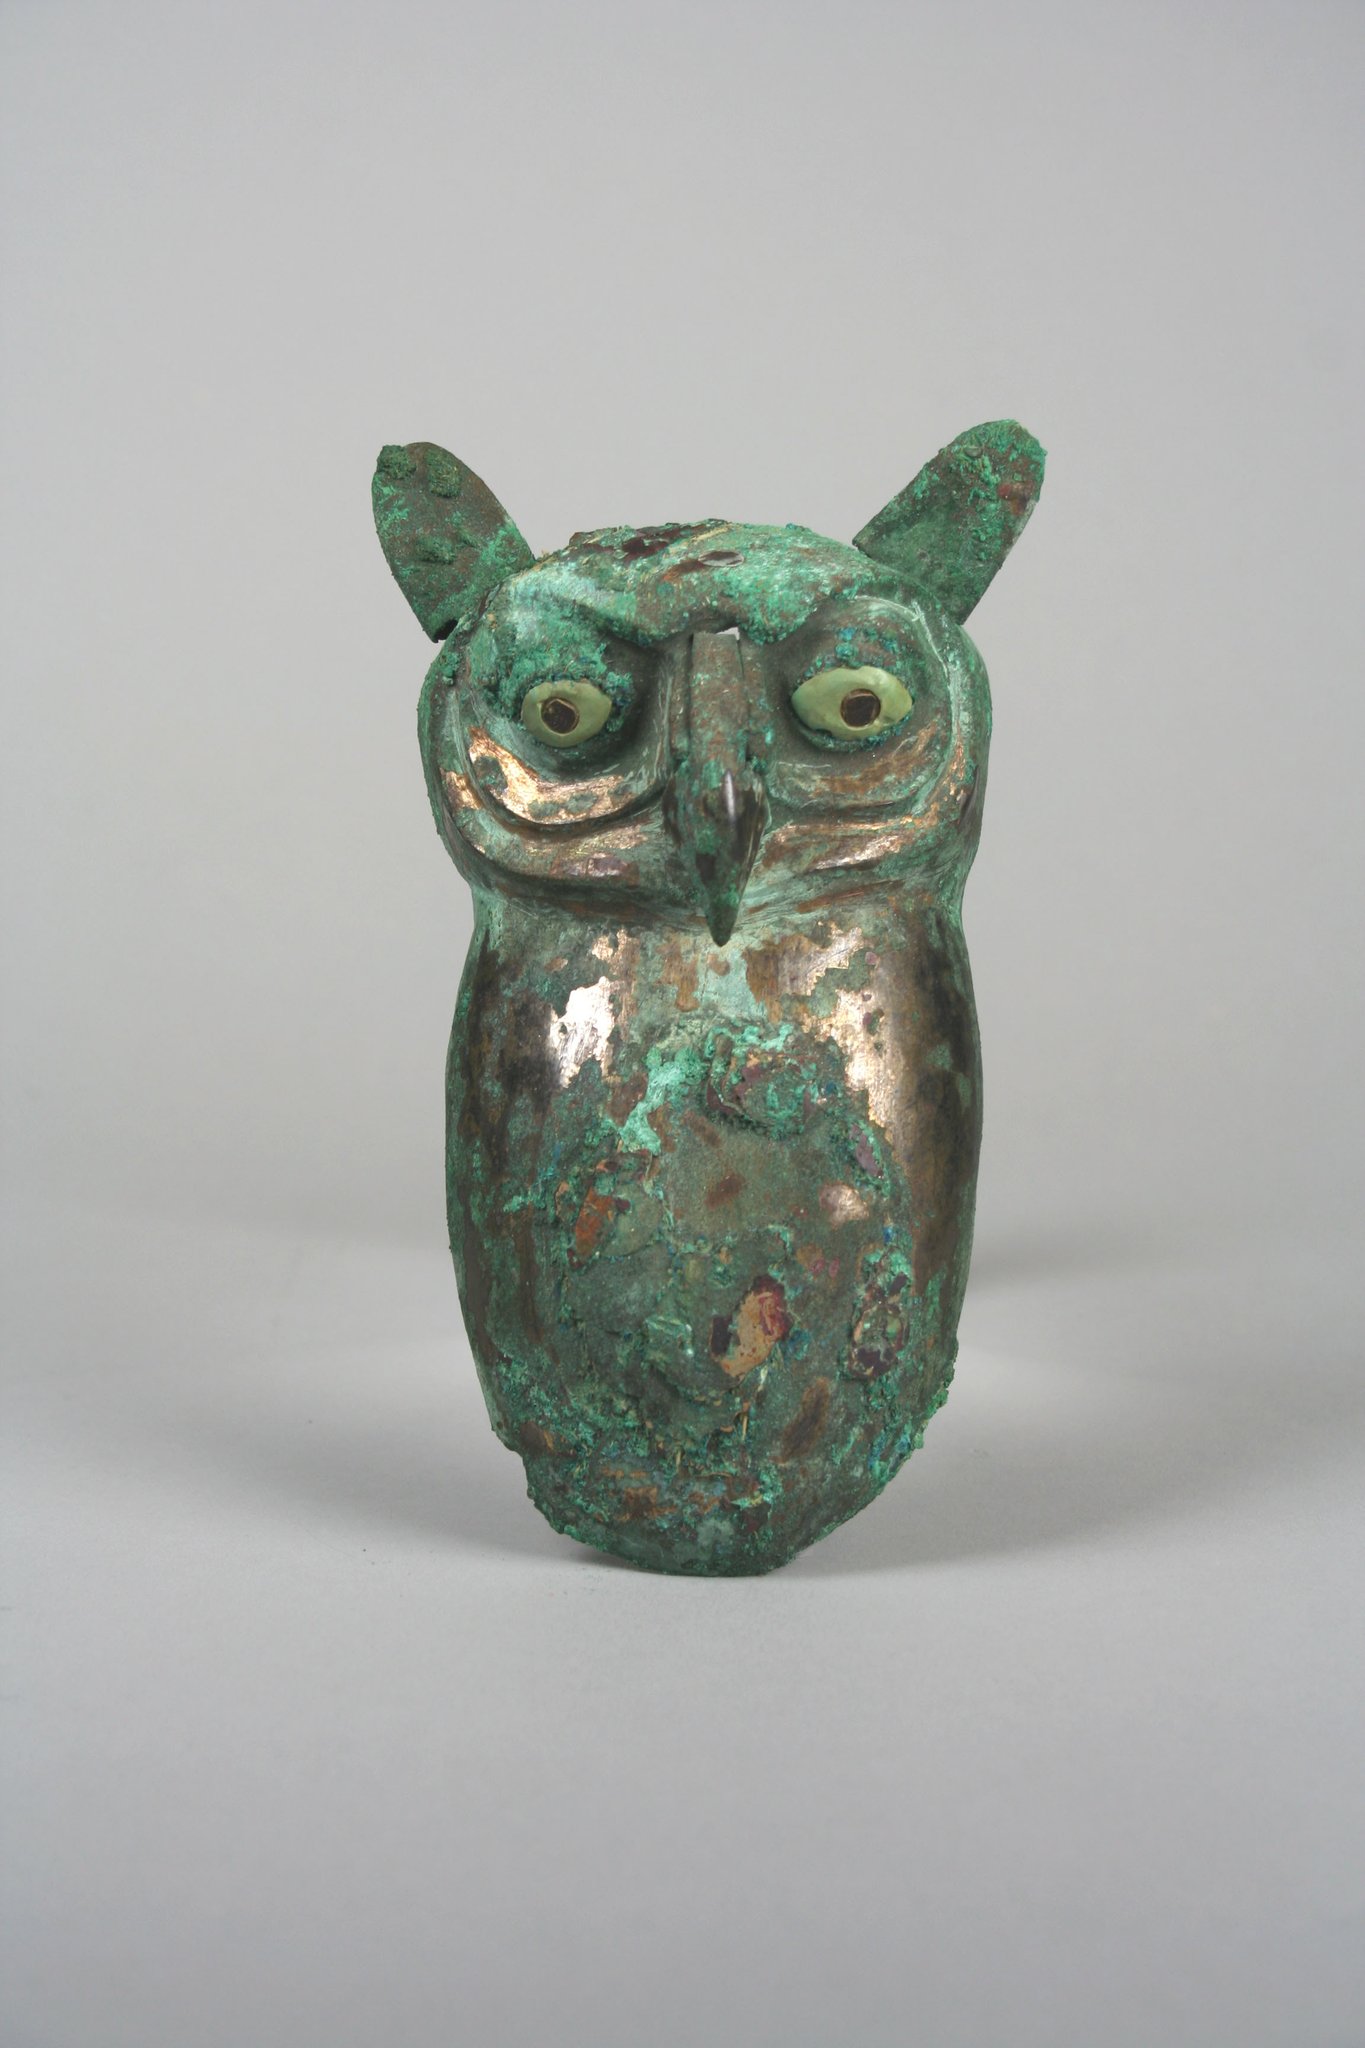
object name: ornament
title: Owl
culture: moche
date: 501-700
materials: shell, metal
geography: peru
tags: owls